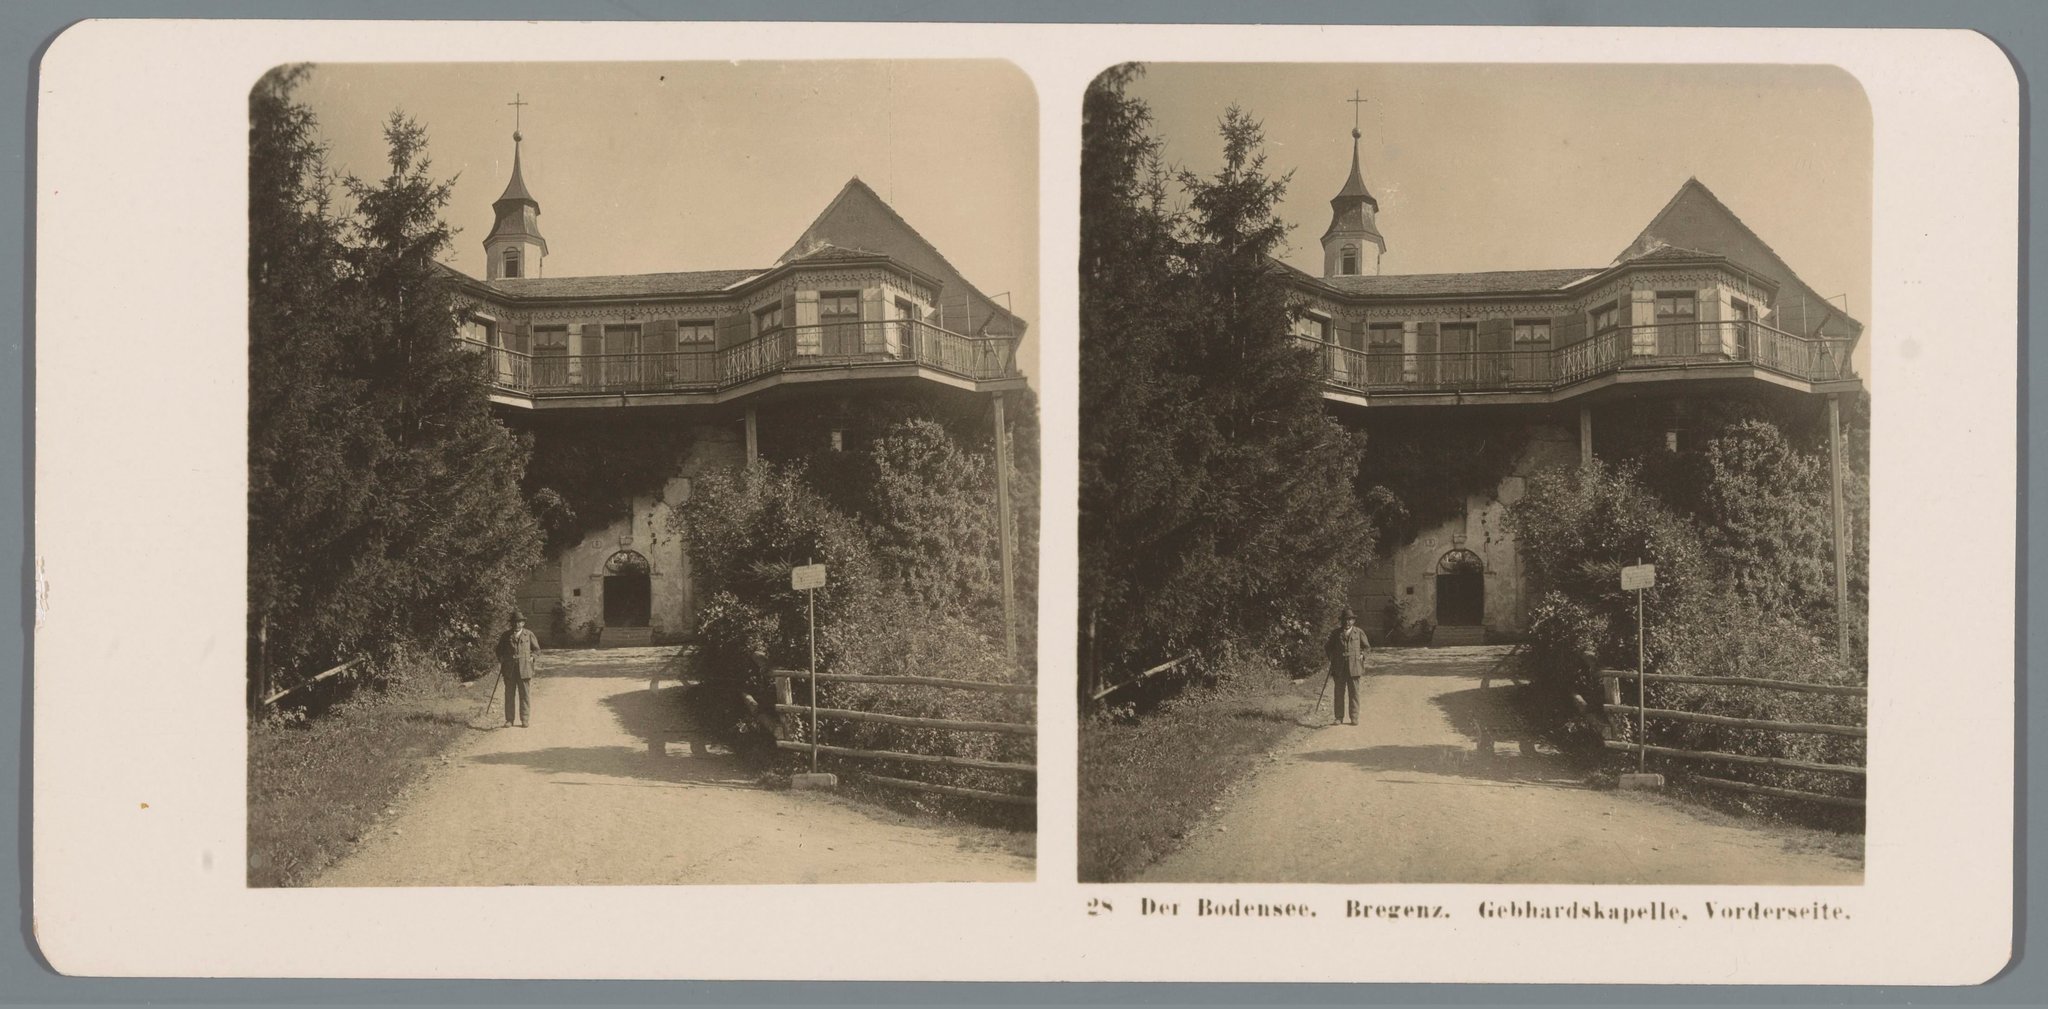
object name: stereograph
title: Gevel van een kapel te Bregenz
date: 1906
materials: cardboard, photographic support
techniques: gelatin silver print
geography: bregenz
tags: church (exterior) - qq - small church, chapel, façade (of house or building)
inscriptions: number: ‘28’, inscription: ‘Neue Photographische Gesellschaft A. G., Steglitz-Berlin 1906.’